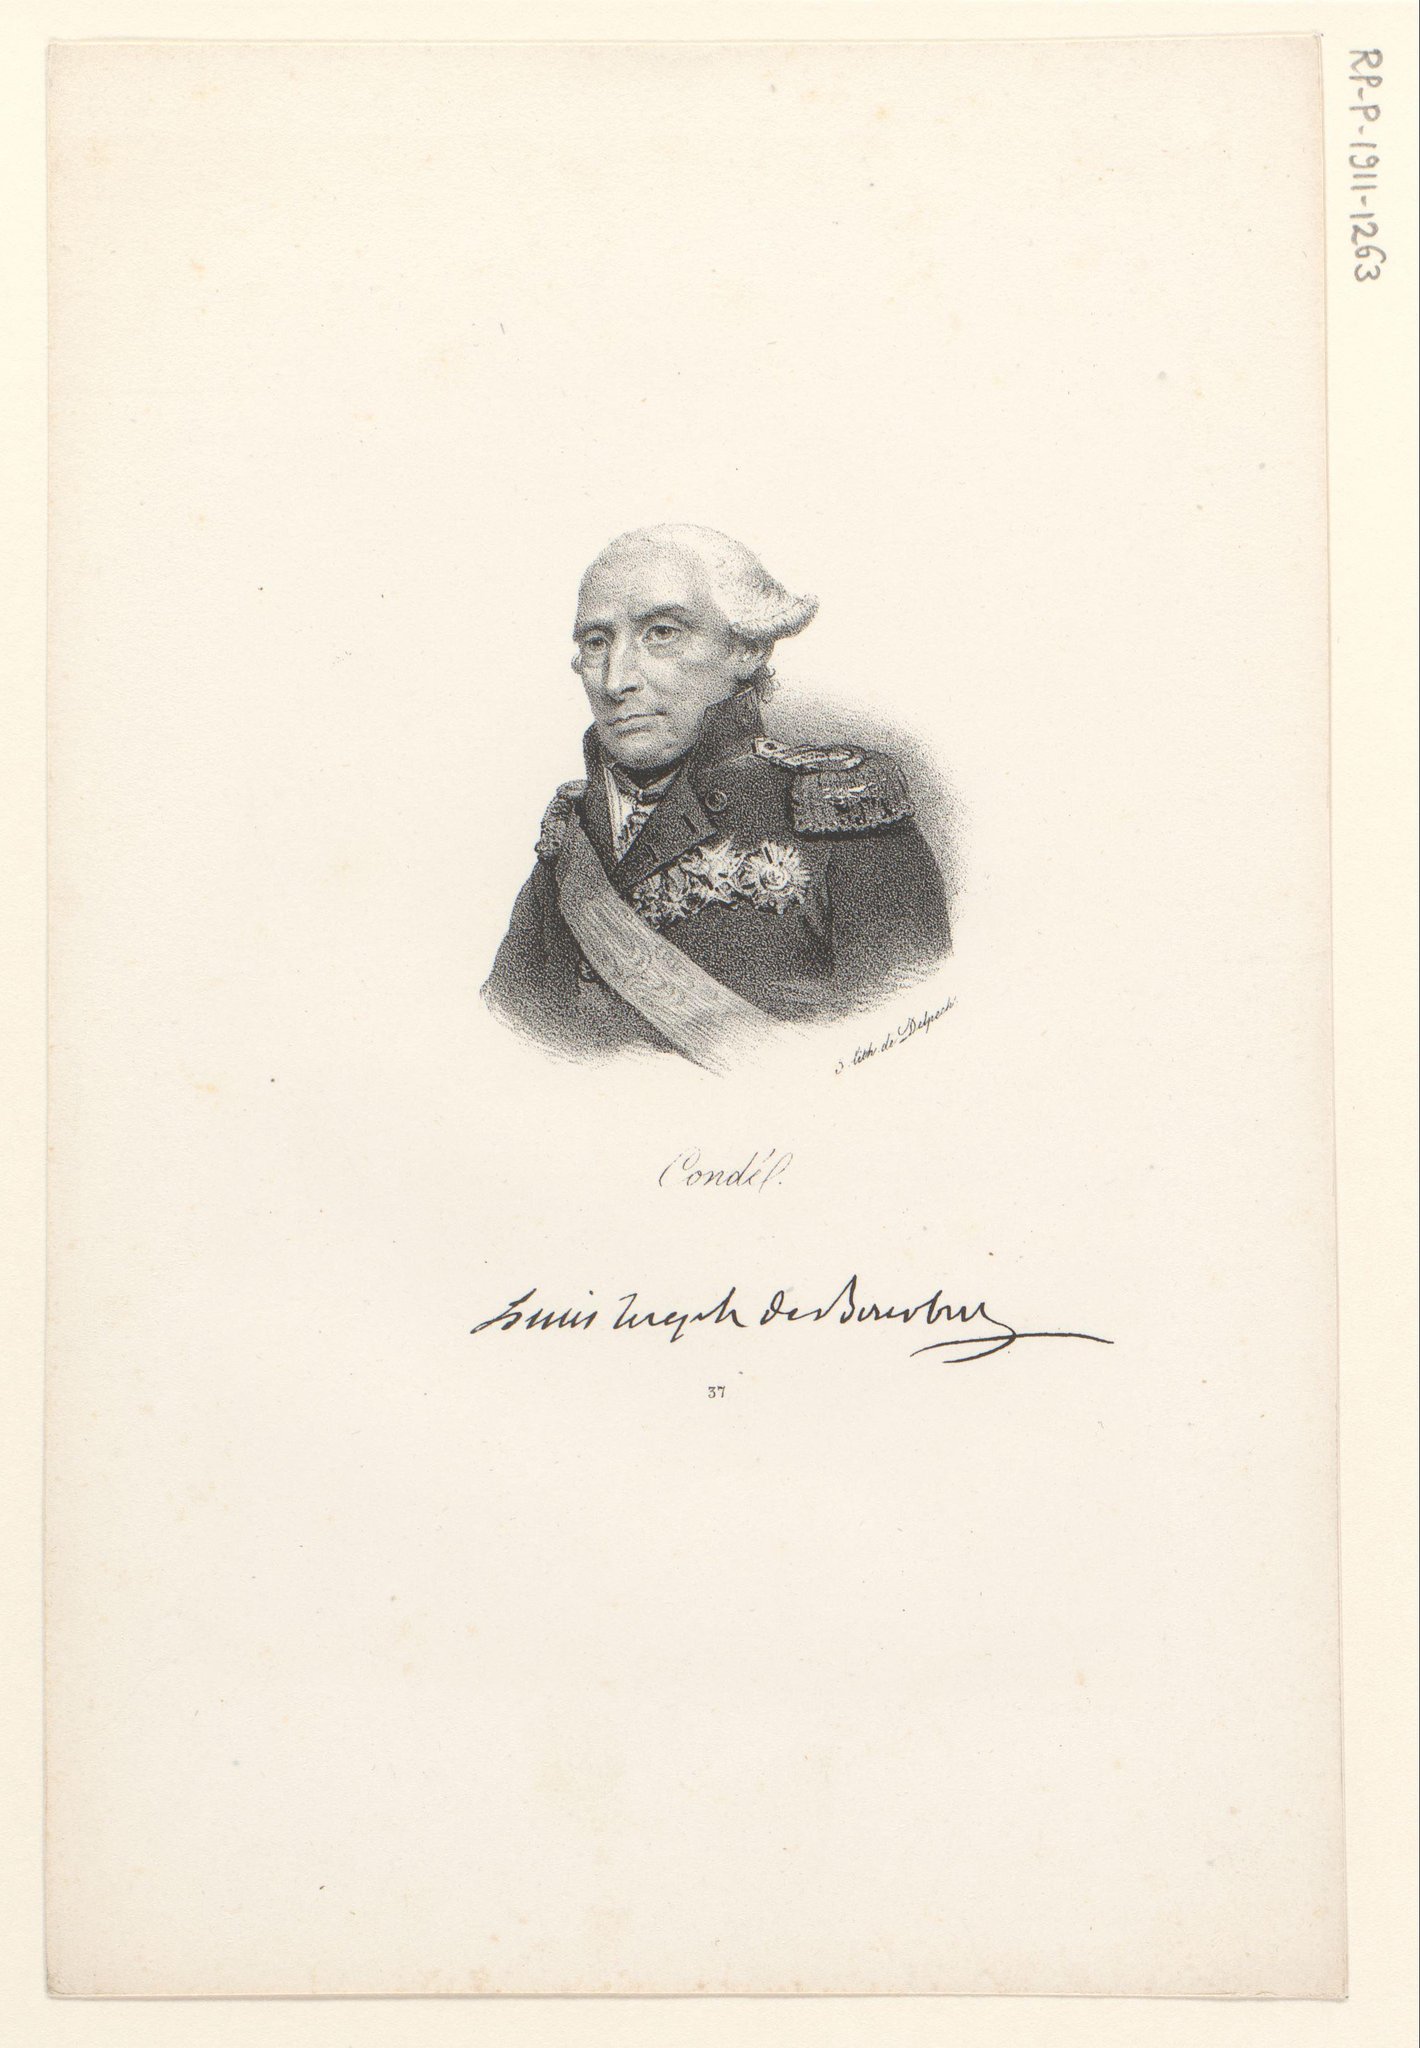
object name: print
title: Portret van Lodewijk V Jozef de Bourbon-Condé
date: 1818-1842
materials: paper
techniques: lithograph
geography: paris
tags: paris, chantilly, louis v joseph van bourbon-condé, historical persons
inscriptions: collector's mark: Lugt 2228a